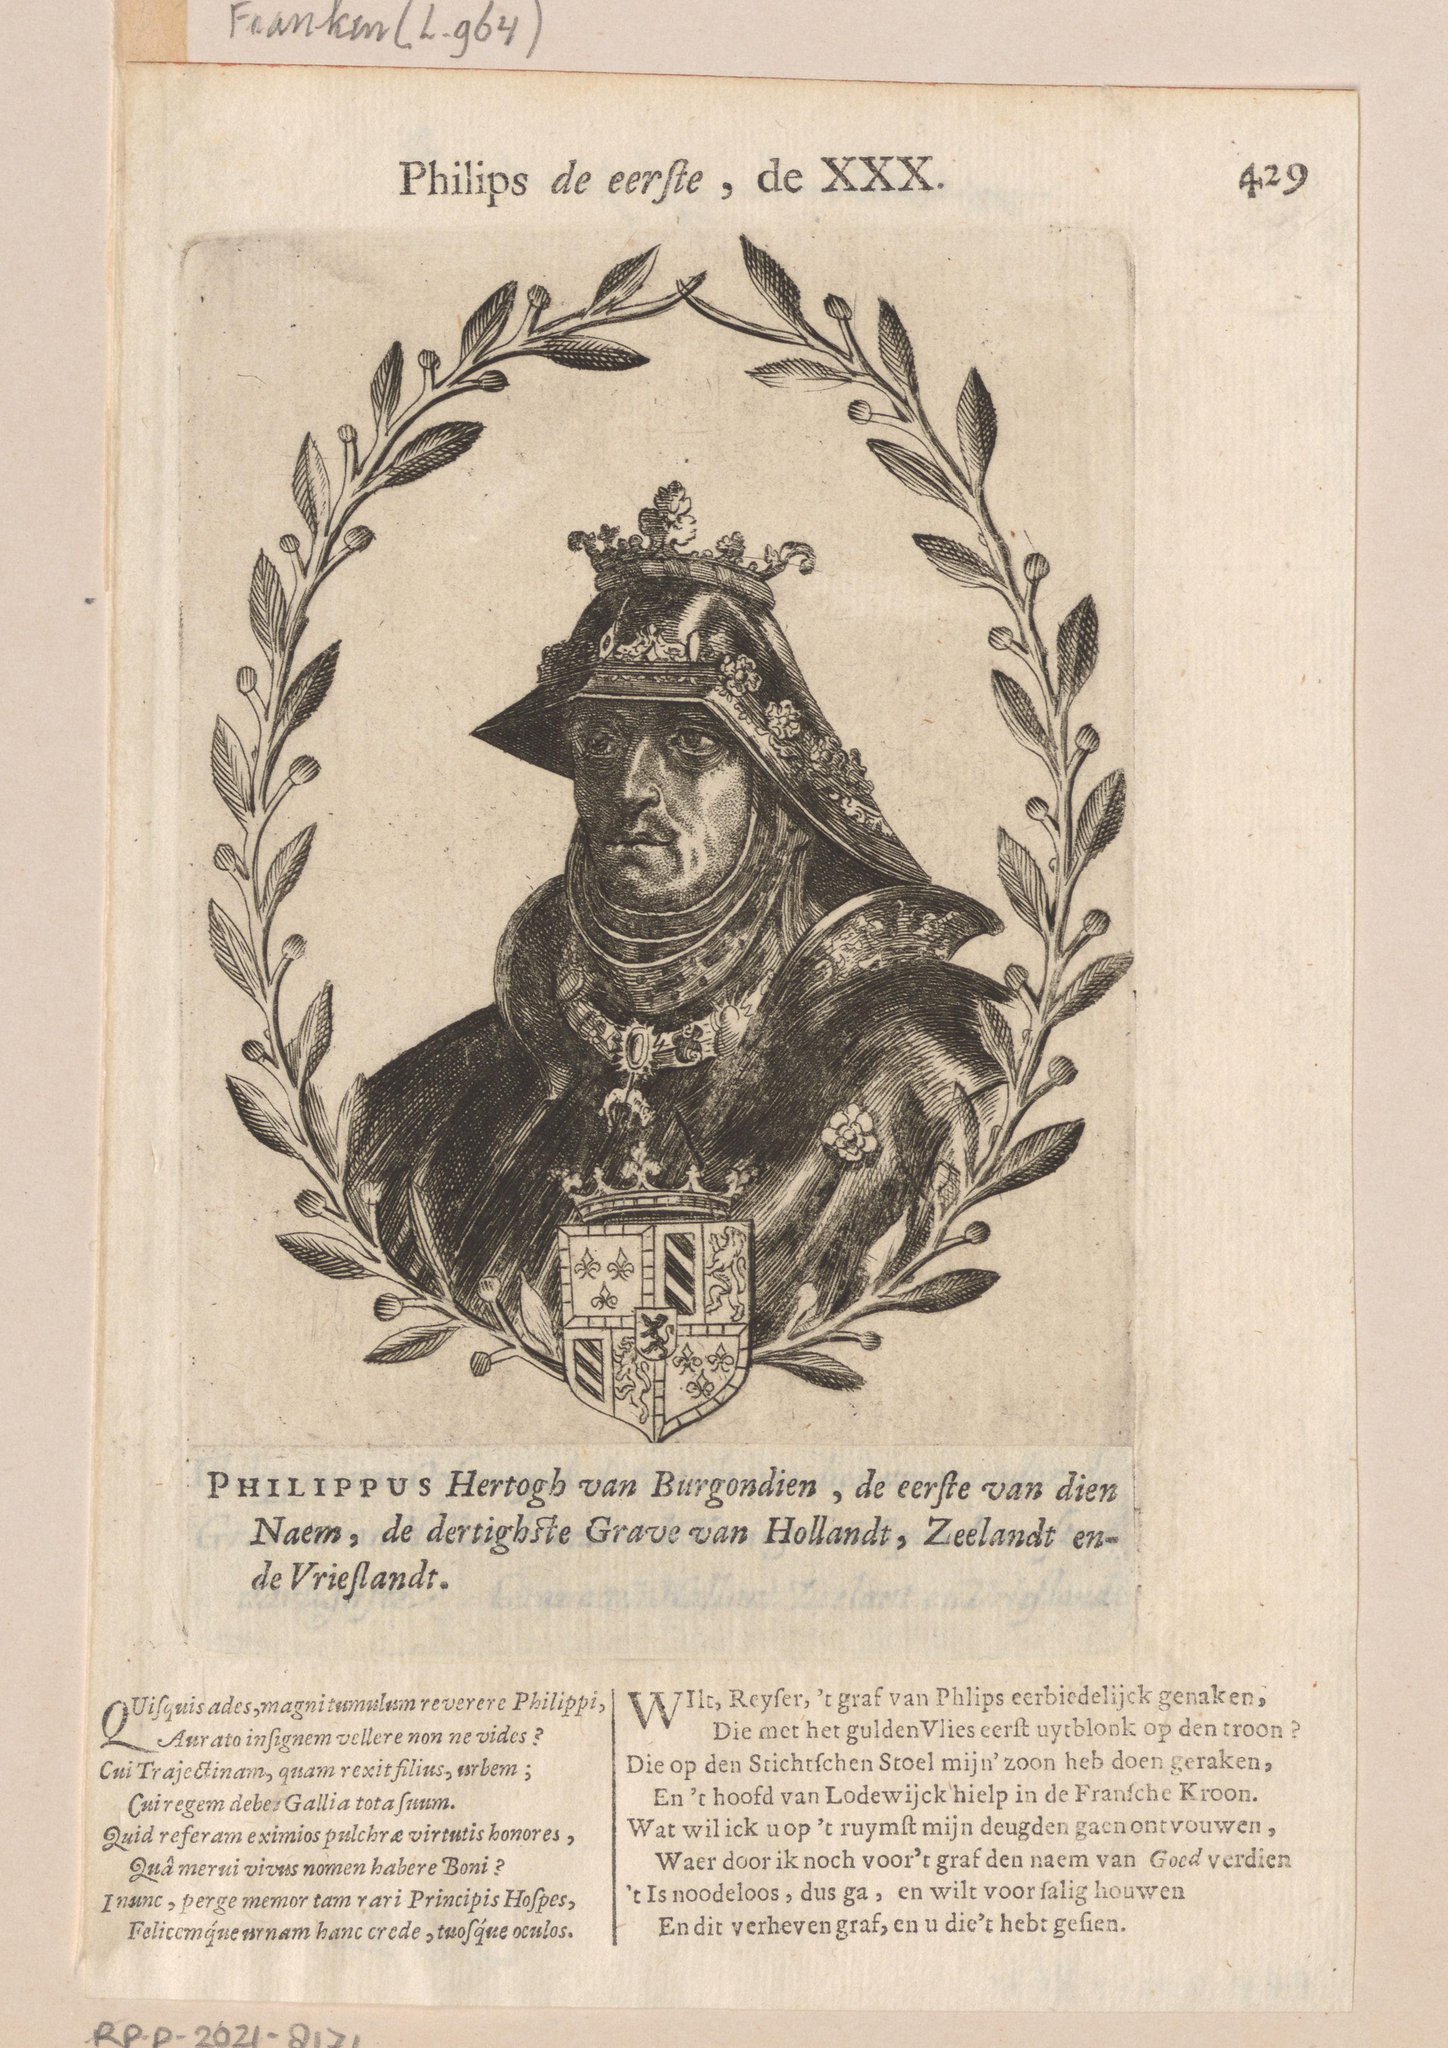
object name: book illustration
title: Portret van Filips de Schone, hertog van Bourgondië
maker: Anonymous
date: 1667-1677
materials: paper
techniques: engraving, etching, letterpress printing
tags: bruges, filips de schone (hertog van bourgondië), adult man, historical persons, knighthood order of the golden fleece, armorial bearing, heraldry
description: Prent mogelijk uit: Scriverius, Petrus. Oude en nieuwe beschryvinge van Holland, Zeeland en Vriesland. Den Haag: Pieter Brugman, 1667. Of uit: Scriverius, Petrus. Hollandsche, Zeelandsche ende Vriesche Chronyk. Den Haag: Johan Veely en Jasper Doll, 1677. Over het onderschrift op de prent is een strook chine collé aangebracht met daarop een andere tekst.